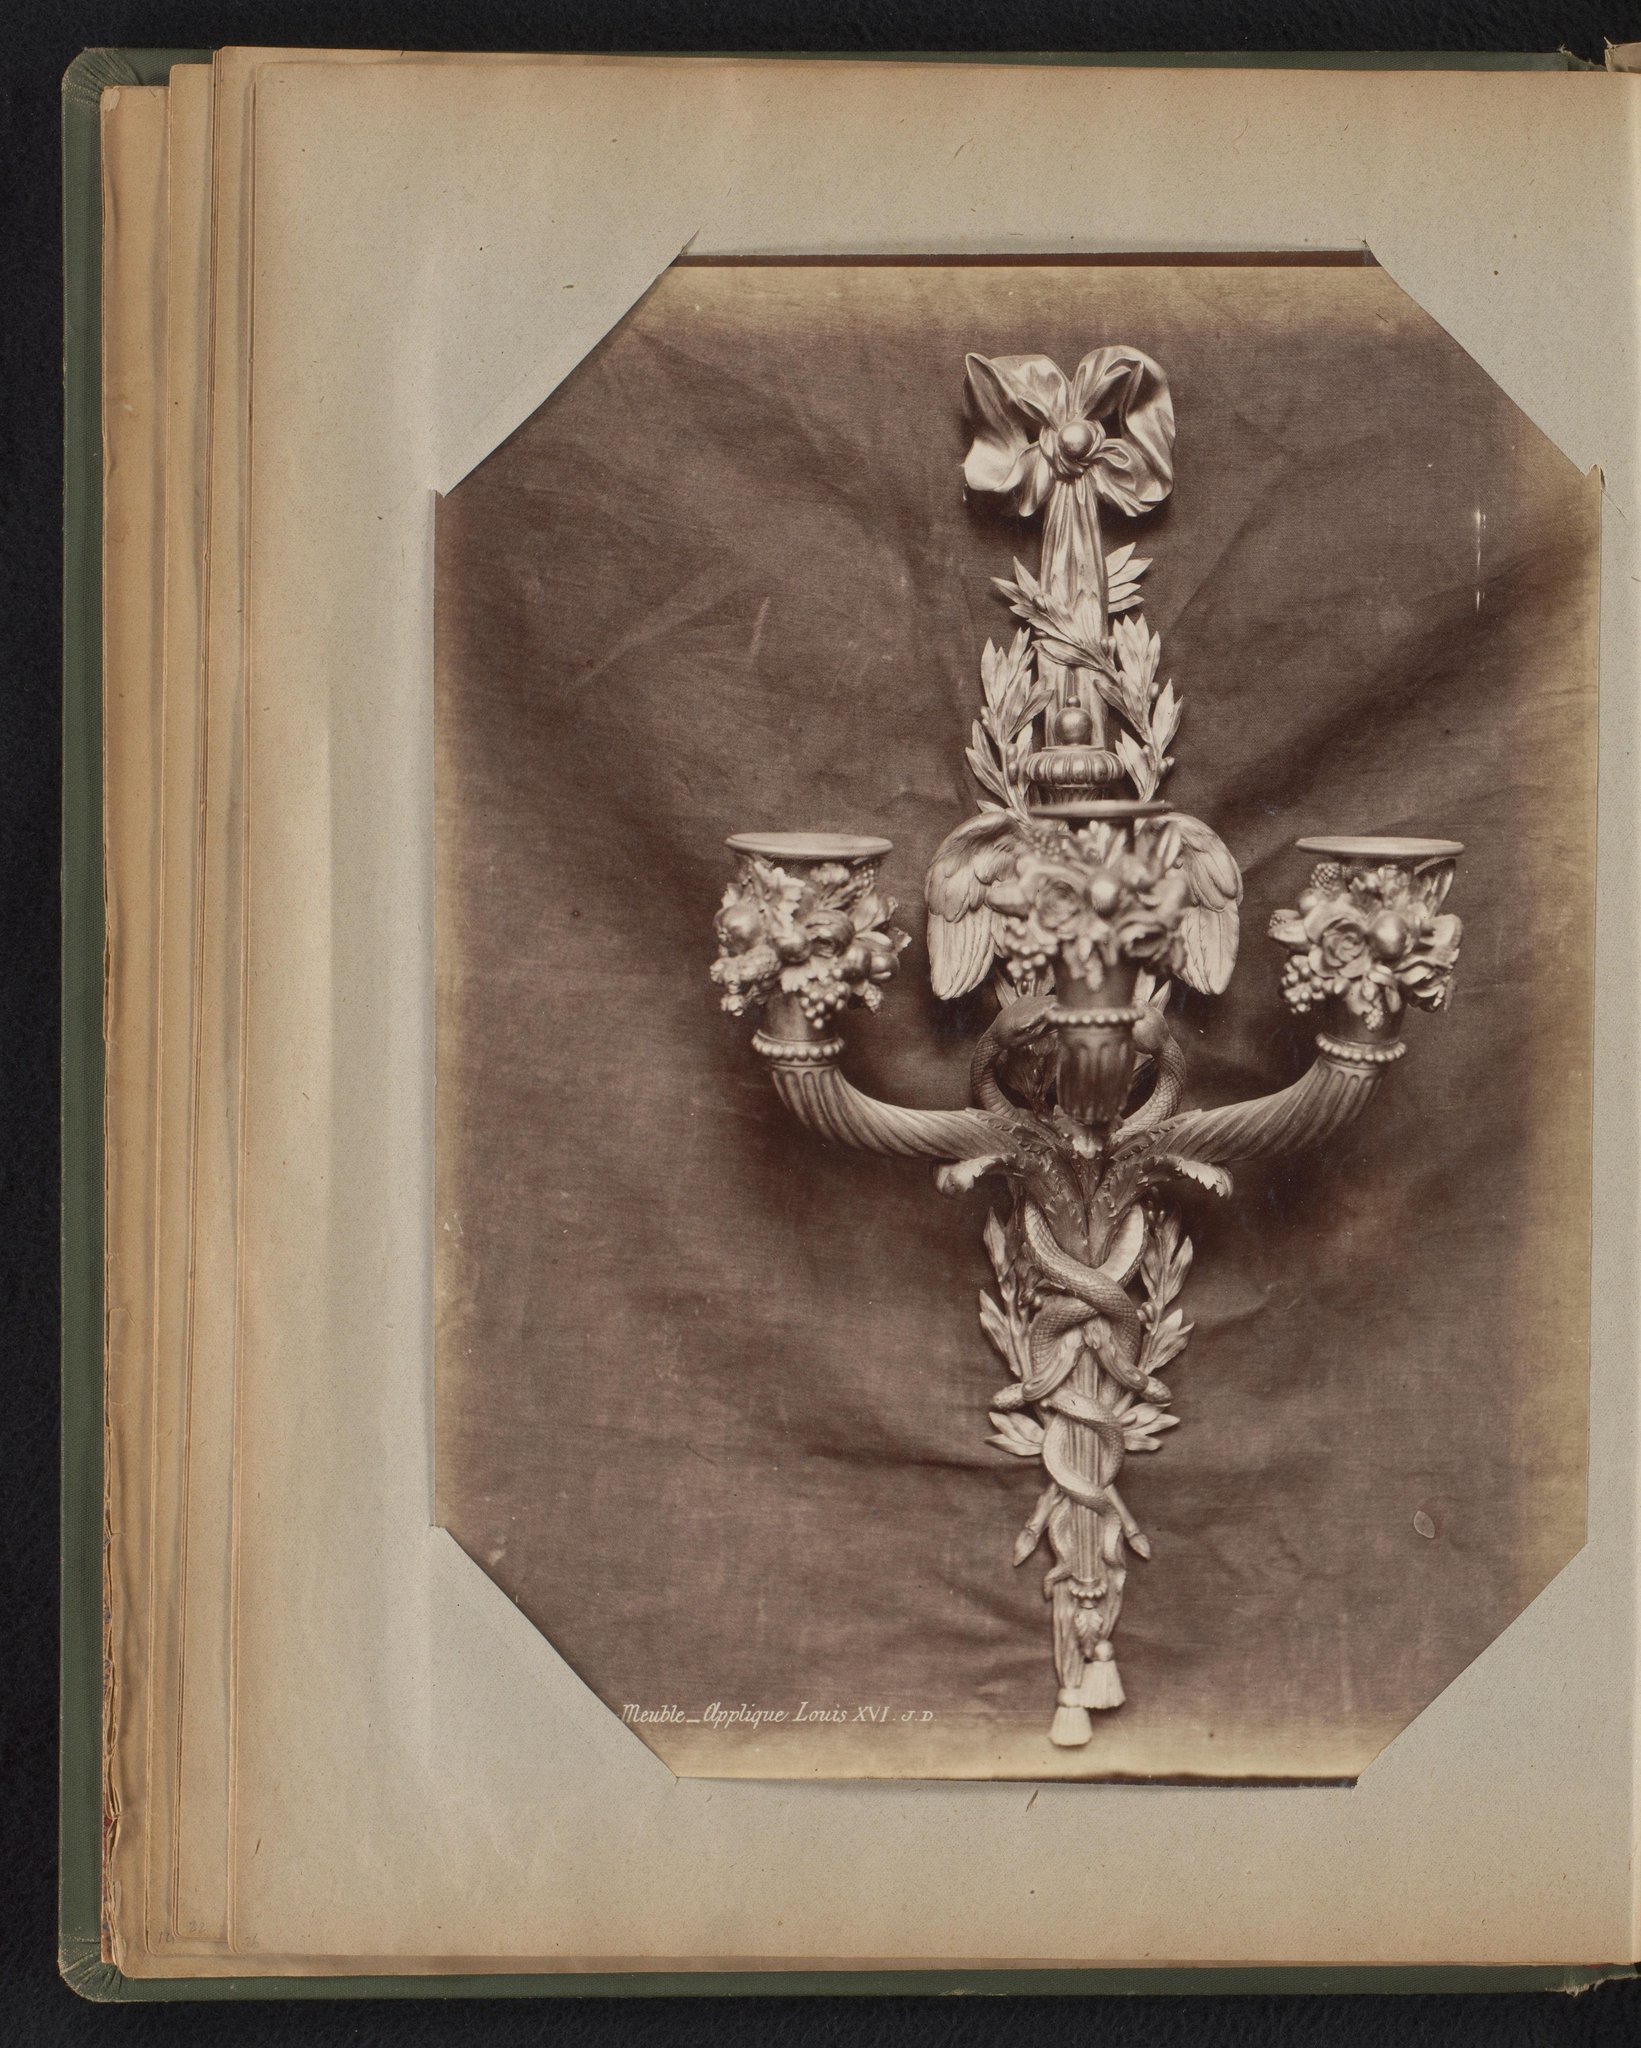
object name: photograph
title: Meuble applique Louis XVI J.D.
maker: Anonymous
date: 1860-1900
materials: canvas, cardboard, paper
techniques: albumen print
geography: netherlands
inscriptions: annotation: ‘Meuble applique Louis XVI J.D.’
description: De midden basis van de kandelaar stelt de caduceus van Hermes voor met twee slangen en vleugels. De foto is onderdeel van een serie met betrekking tot het interieur van het paleis van Versailles met kroonluchters, deuren, portalen en meubelstukken.